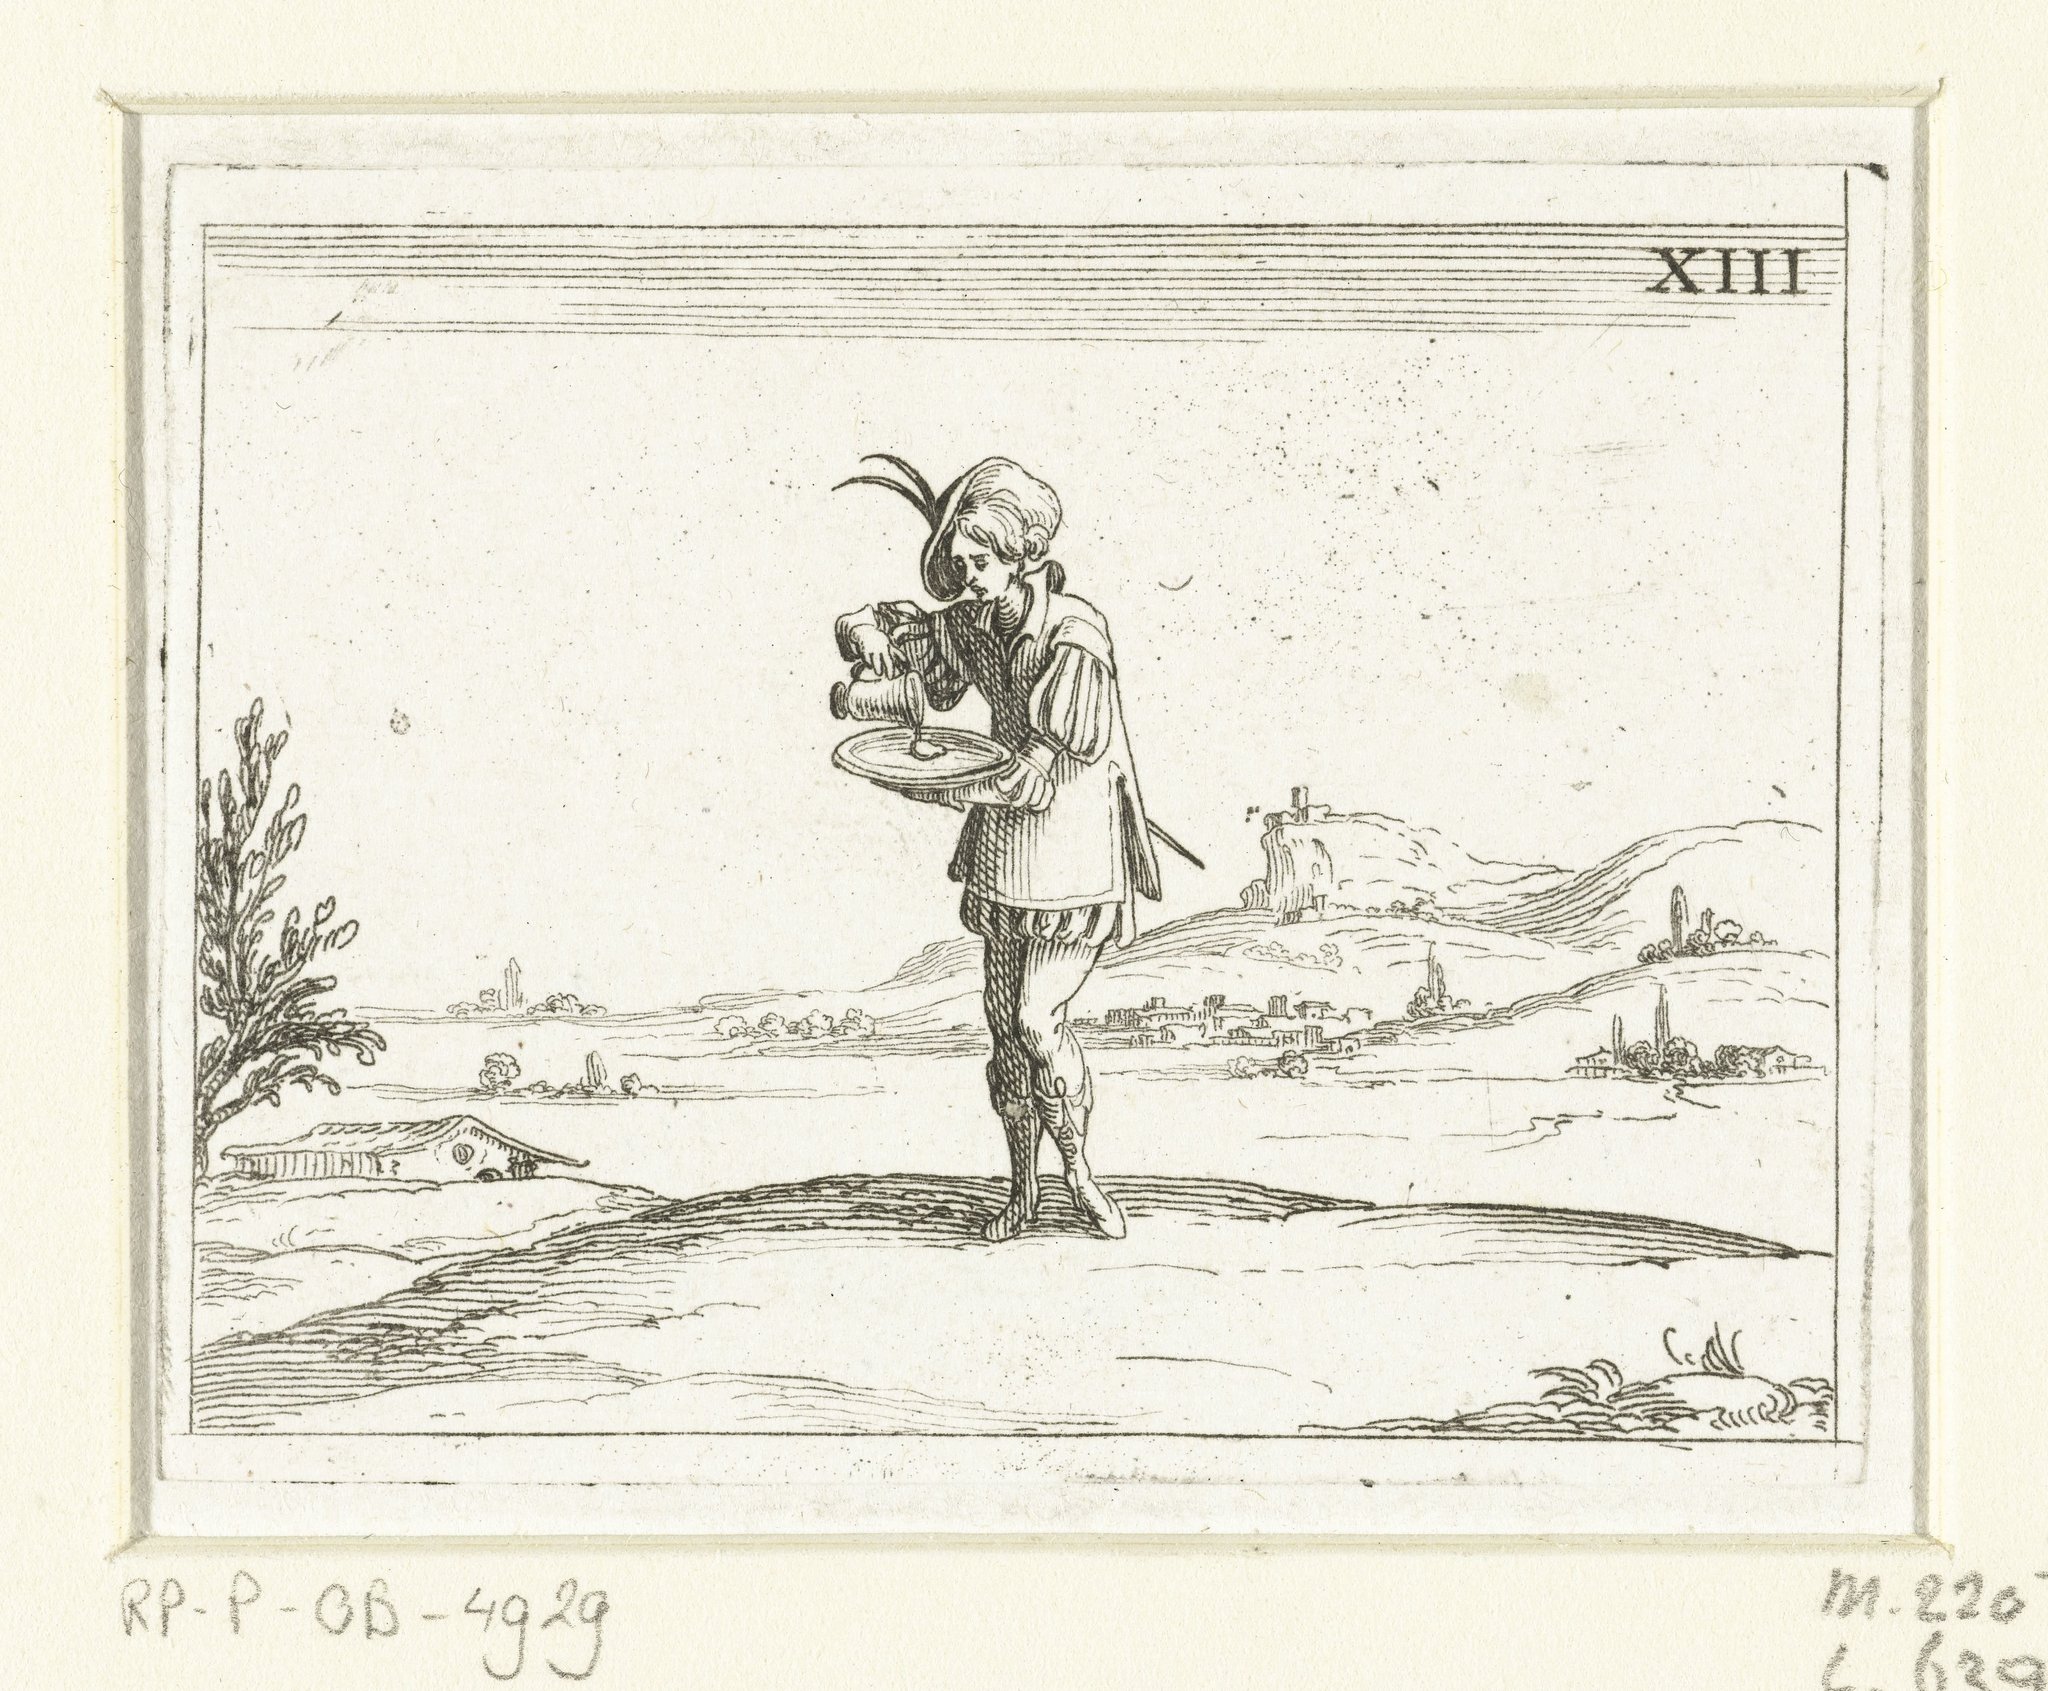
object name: print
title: Een man wast een parel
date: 1625-1629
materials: paper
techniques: etching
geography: nancy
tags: animals (+ pearl ~ product of animal)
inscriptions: collector's mark: Lugt 240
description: Voorstelling van een man, staand in een landschap, die een parel op een schaal begiet met water uit een kan. Dit blad is onderdeel van de embleemserie 'Leven van Maria in emblemen'. De eerste staat van deze serie behelst naast een titelpagina en 26 emblemen ook drie bladen met lofzangen op Maria in boekdruk zonder afbeelding.